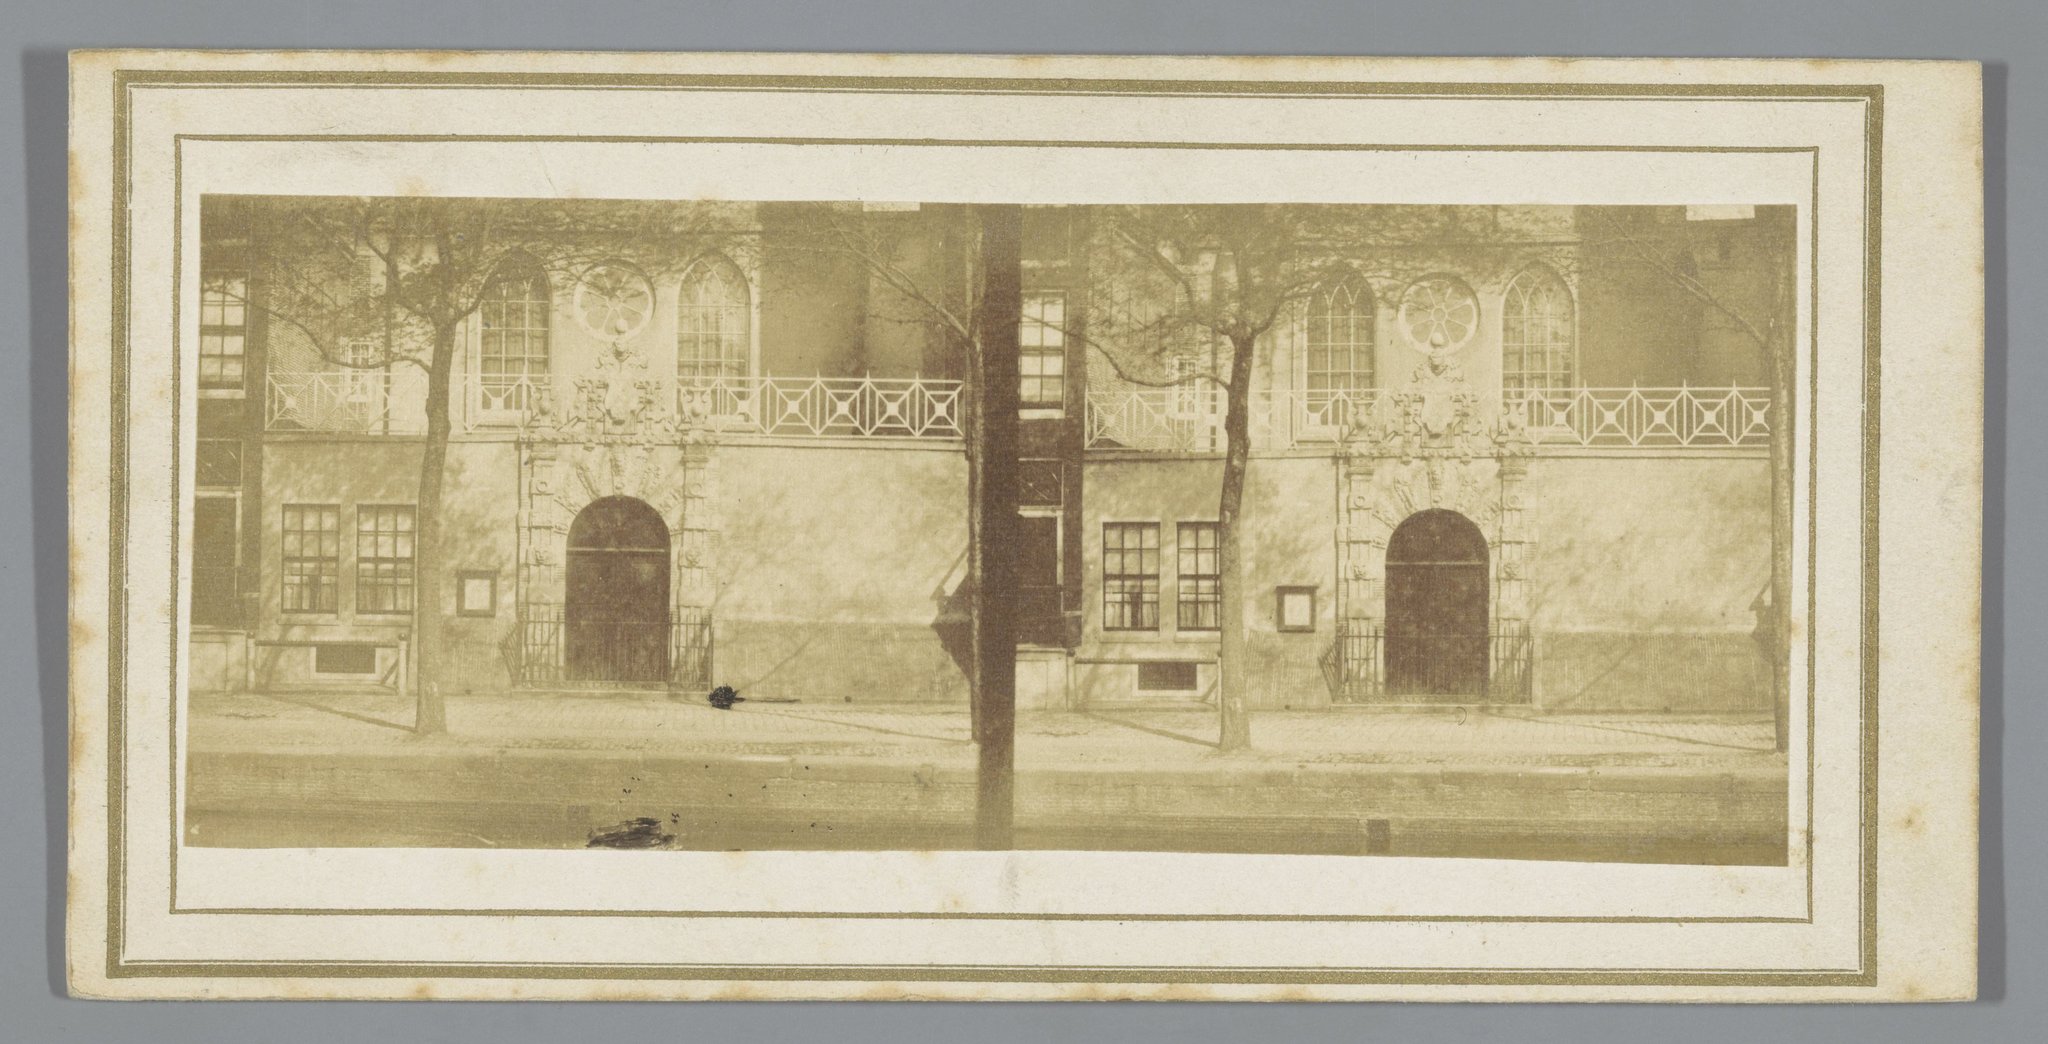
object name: stereograph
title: Amsterdam, St. Agnieten Kapel, O.Z. Voorburgwal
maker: pieter oosterhuis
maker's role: draughtsman, print maker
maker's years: 1816-1885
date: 1856-1861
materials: cardboard, paper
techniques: albumen print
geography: amsterdam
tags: gate, entrance, street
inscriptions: inscription: ‘Piet/’, inscription: ‘Photographie van P. Oosterhuis, N.Z. Voorburgwal, bij het Spui.’